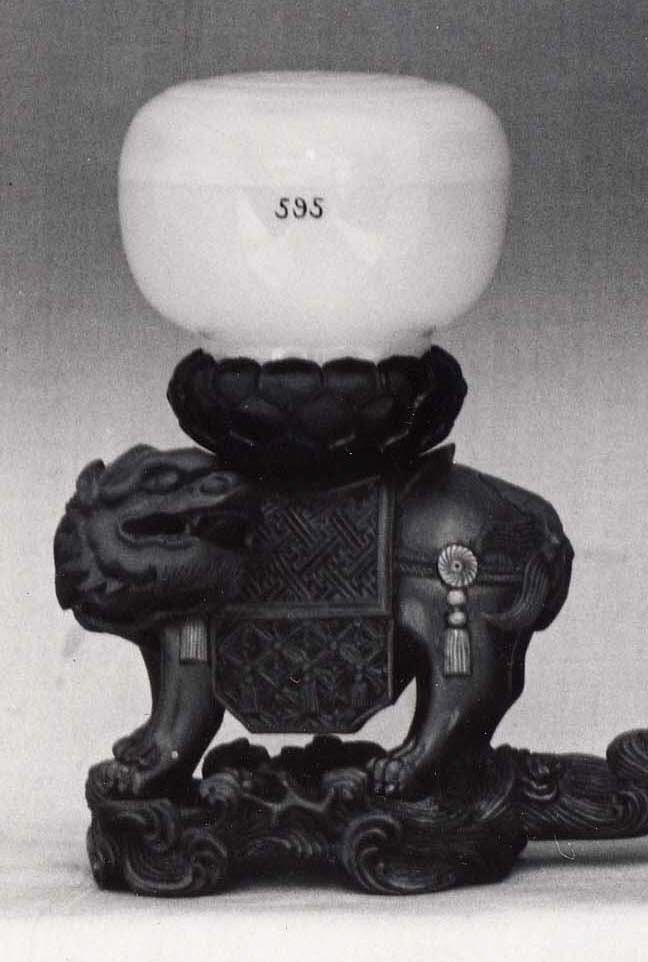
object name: box with cover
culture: chinese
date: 1701-1800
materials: jade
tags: animals